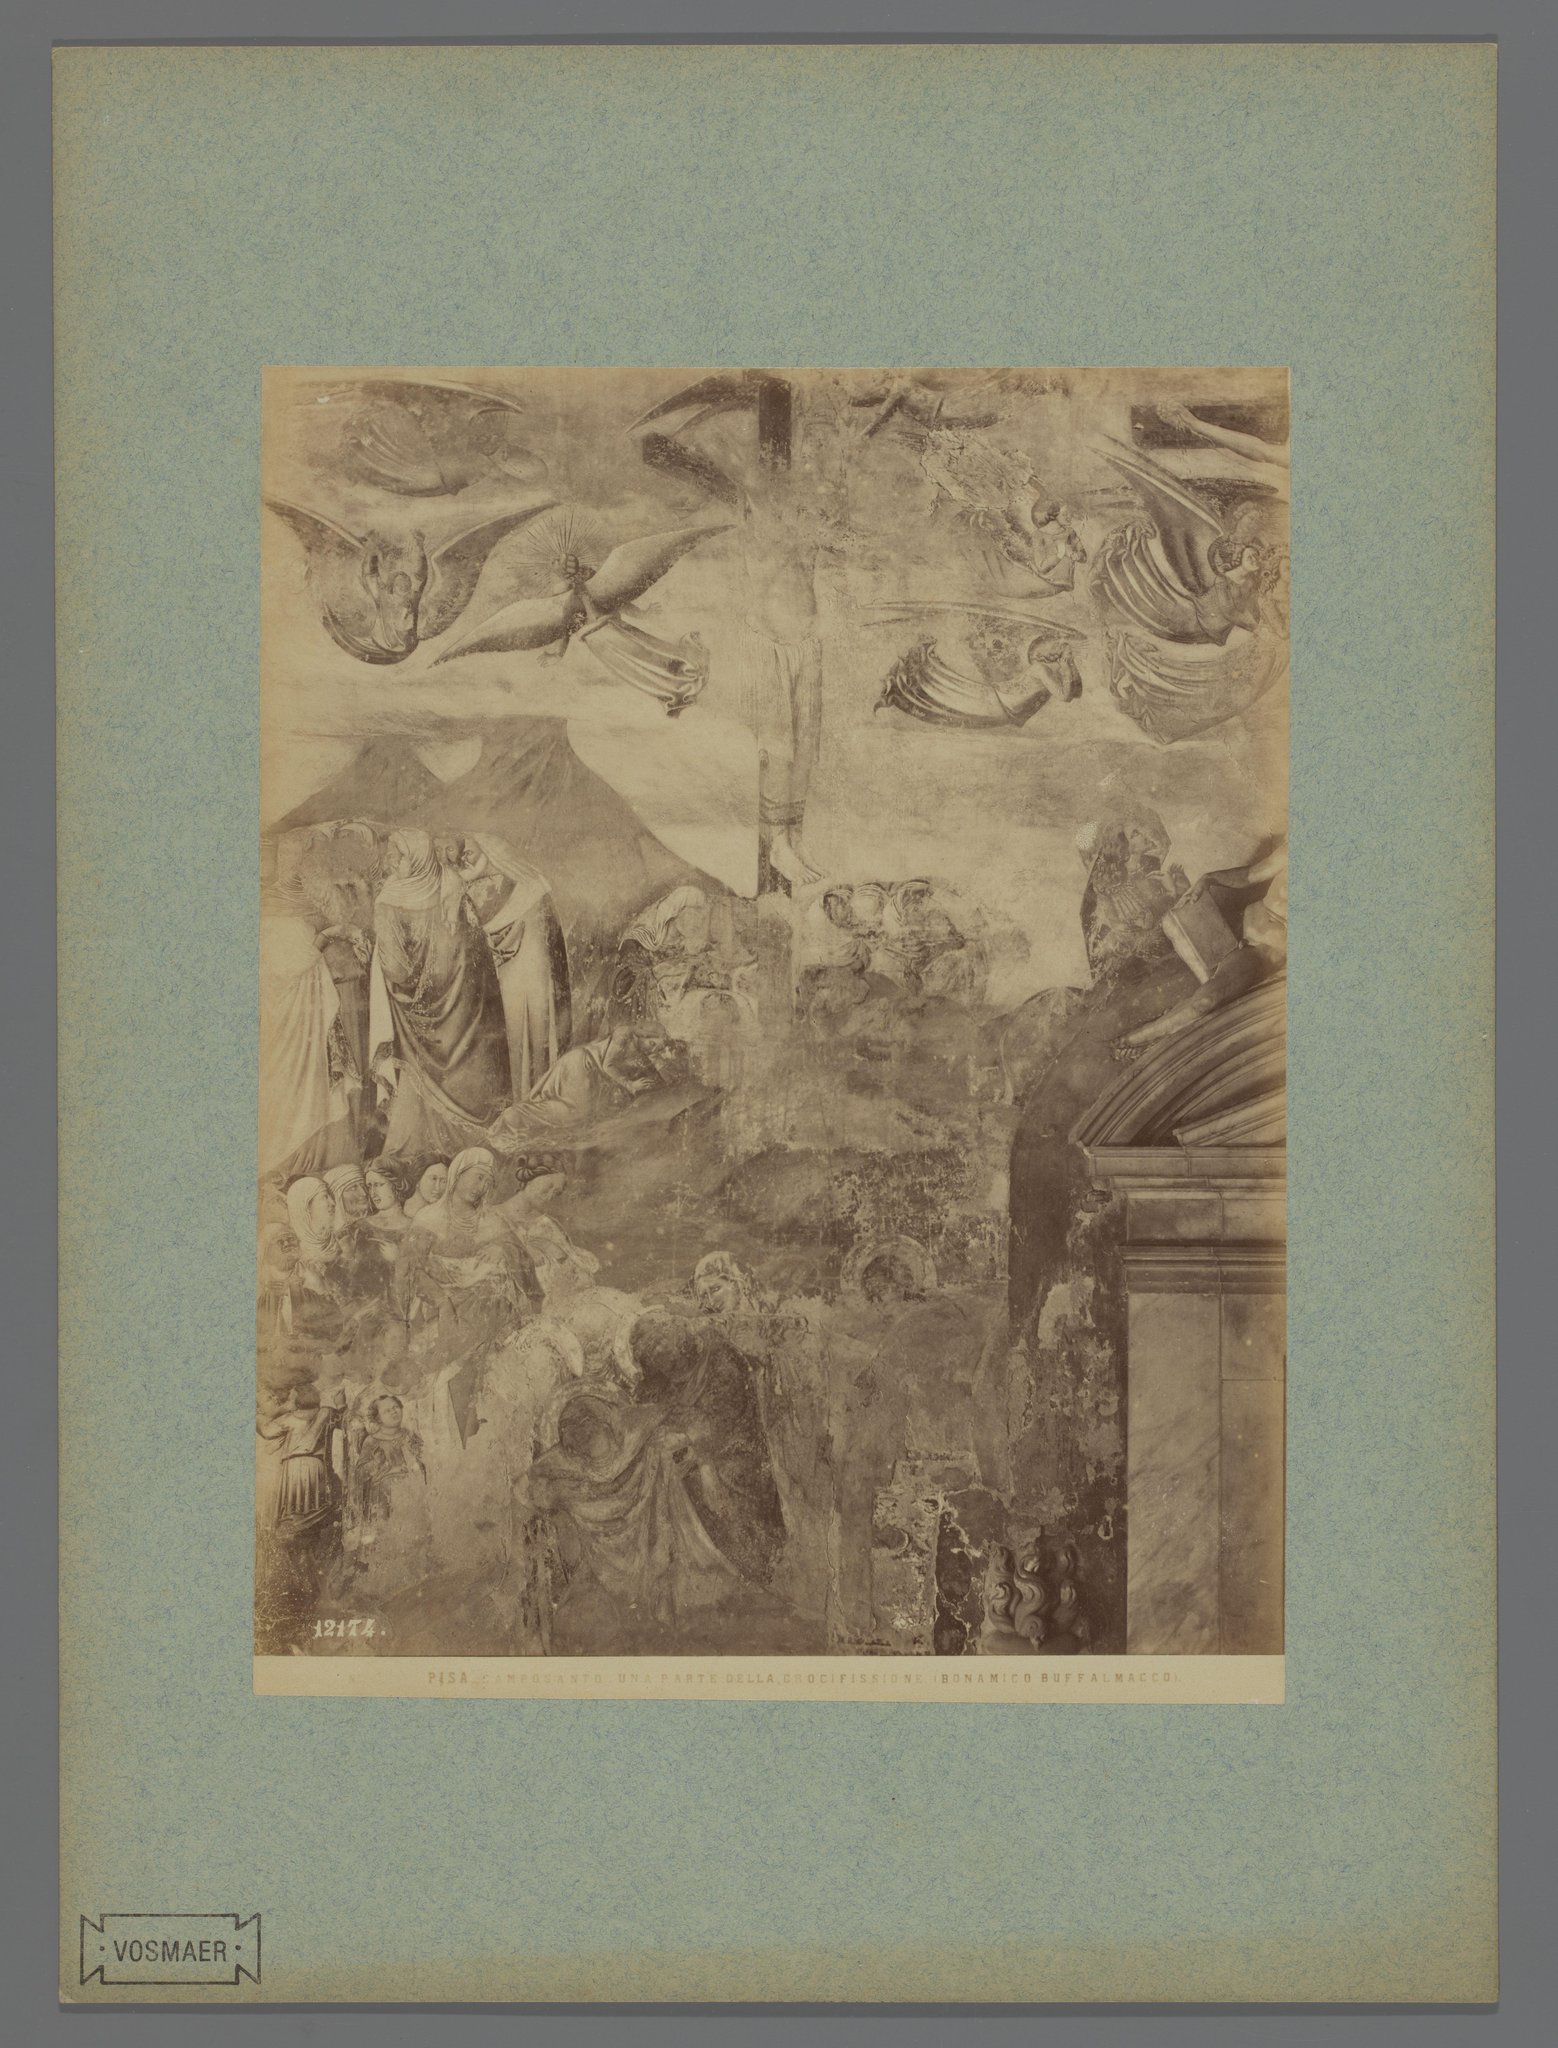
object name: reproduction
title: Fotoreproductie van een deel van het fresco Kruisiging door Buffalmacco in het Camposanto te Pisa, Italië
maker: buonamico buffalmacco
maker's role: painter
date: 1852-1900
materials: cardboard, paper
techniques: albumen print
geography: pisa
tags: wall-covering, the crucifixion of christ: christ's death on the cross; golgotha (matthew 27:45-58; mark 15:33-45; luke 23:44-52; john 19:25-38)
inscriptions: collector's mark: ‘VOSMAER’, number: ‘12174.’